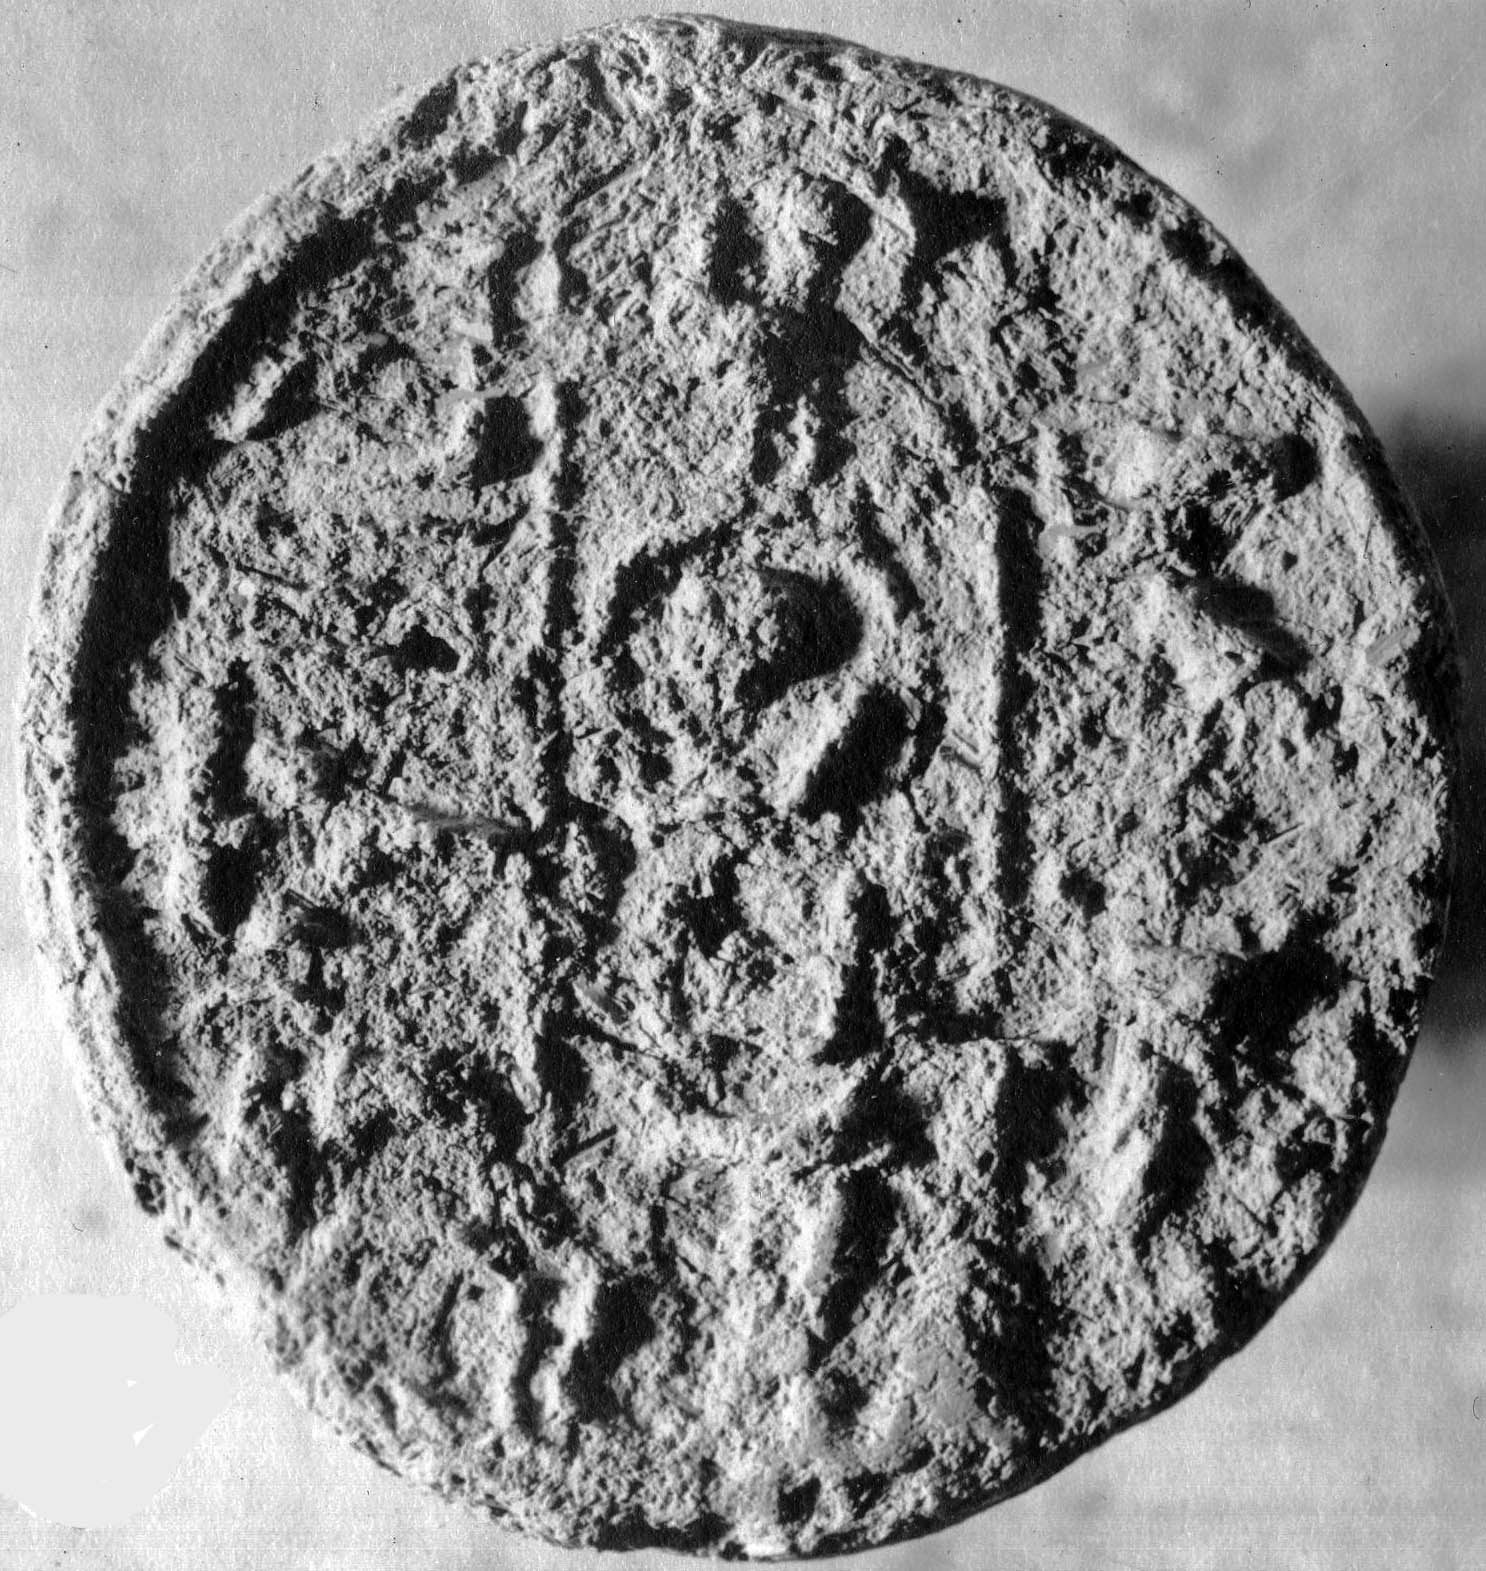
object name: cone, circular impression, amenhotep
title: Funerary Cone of Amenemhab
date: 1550-1295 BCE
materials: pottery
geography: egypt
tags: hieroglyphs